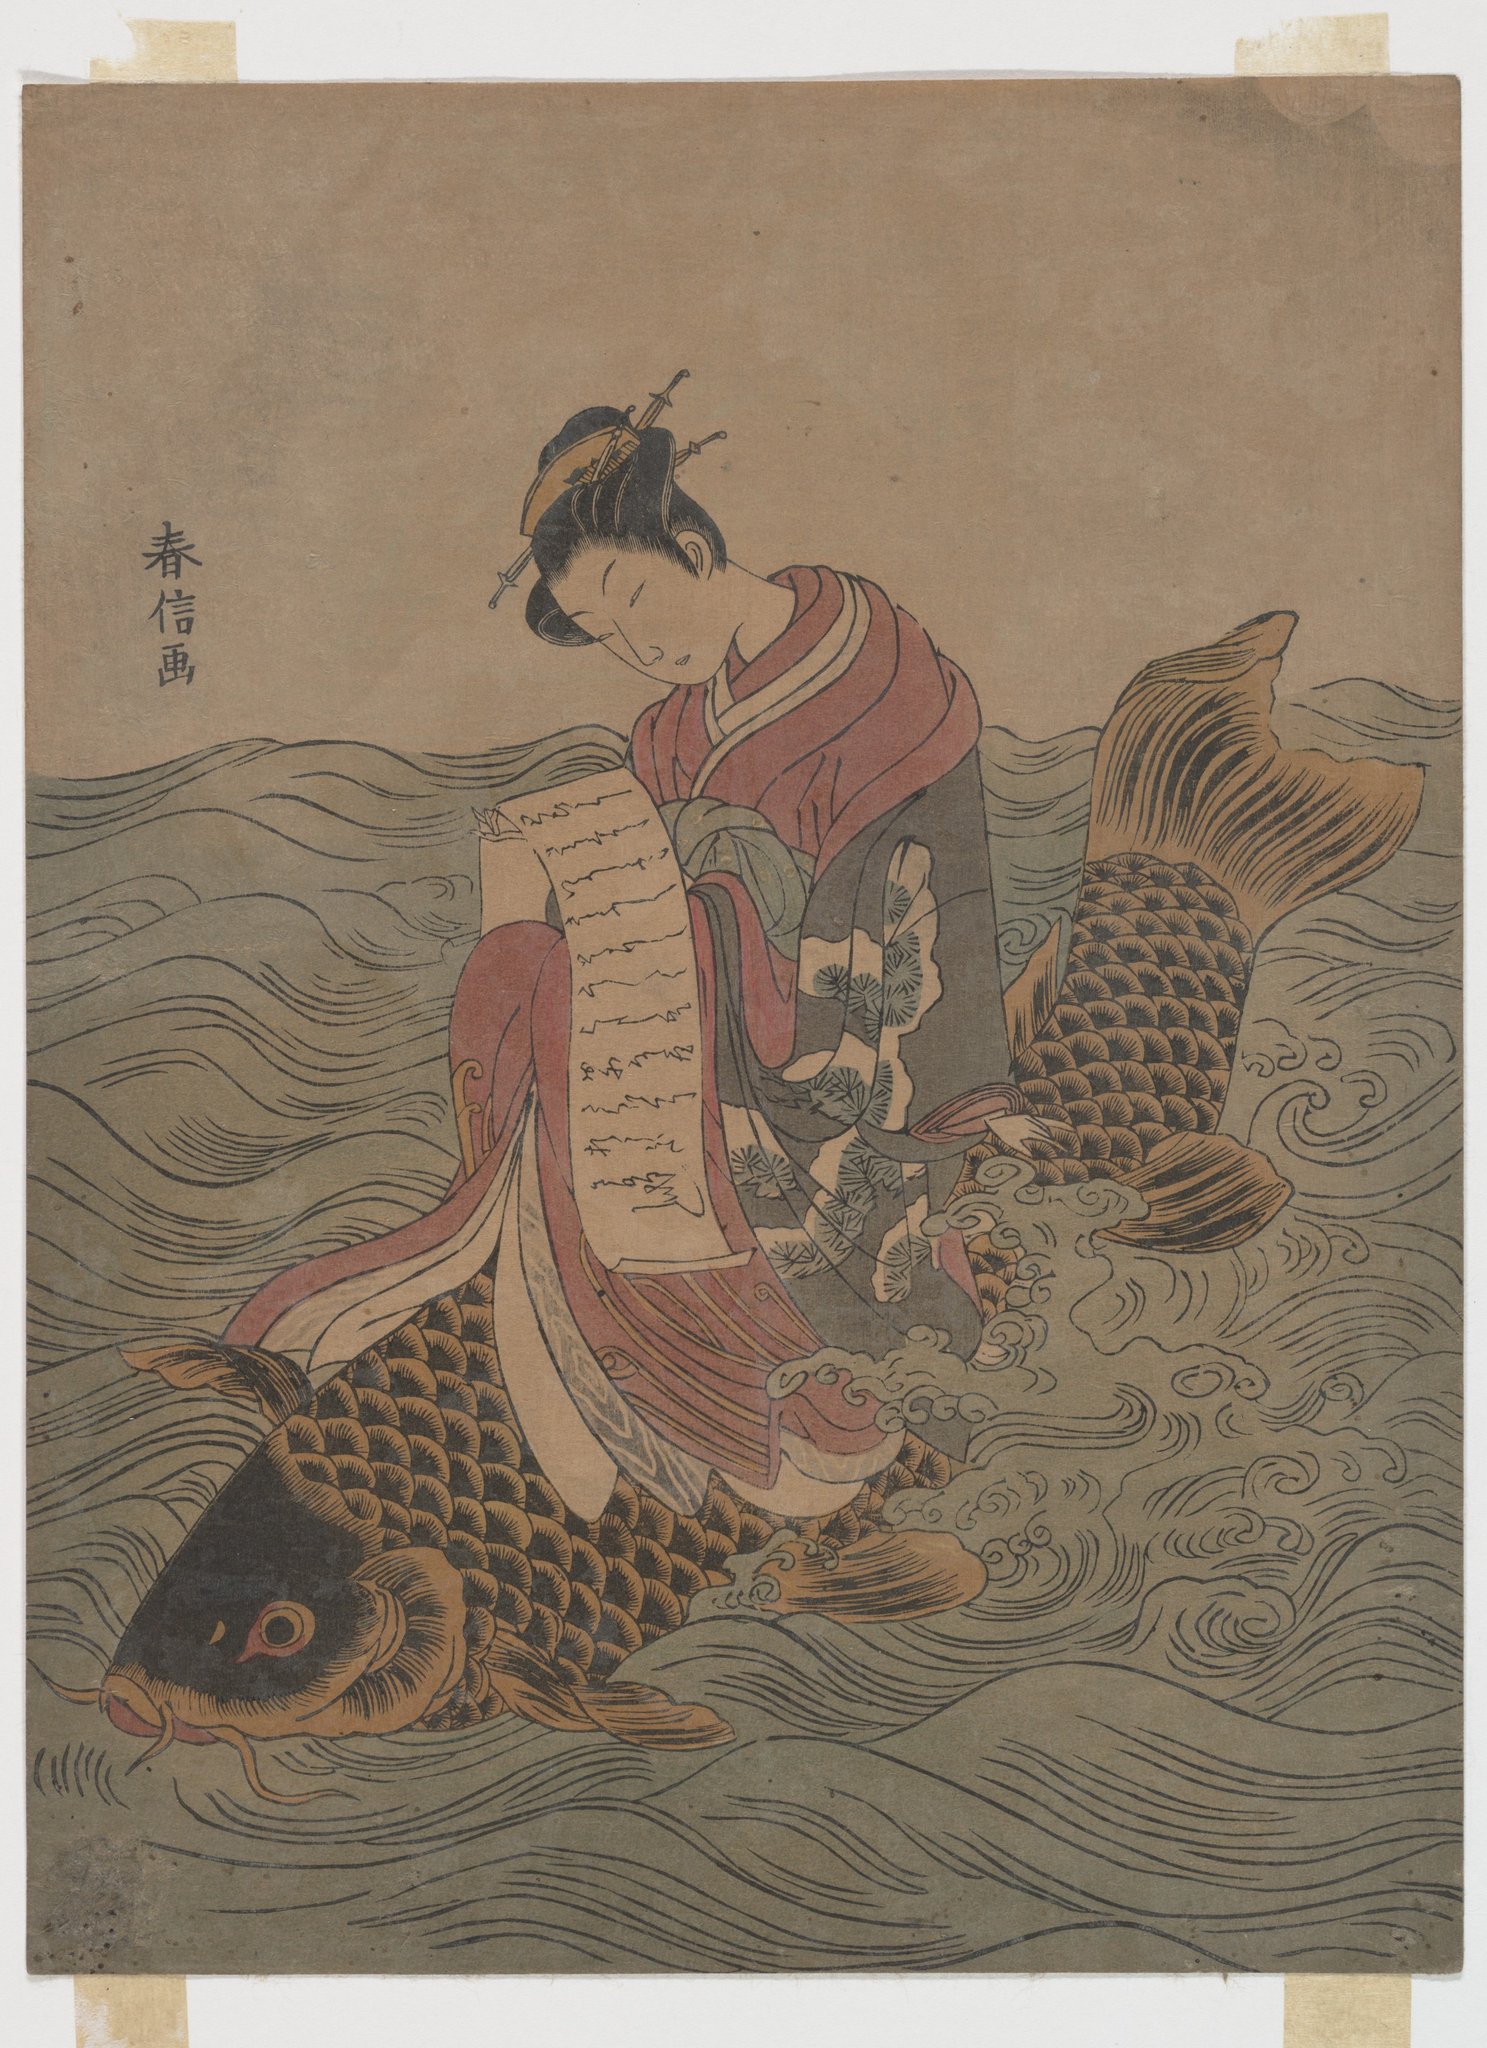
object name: print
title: Young Woman Riding a Carp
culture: japanese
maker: suzuki harunobu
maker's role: artist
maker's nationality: japanese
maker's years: 1725-1770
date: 1760-1769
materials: ink, paper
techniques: nishiki e, woodblock print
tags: women,reading,fish